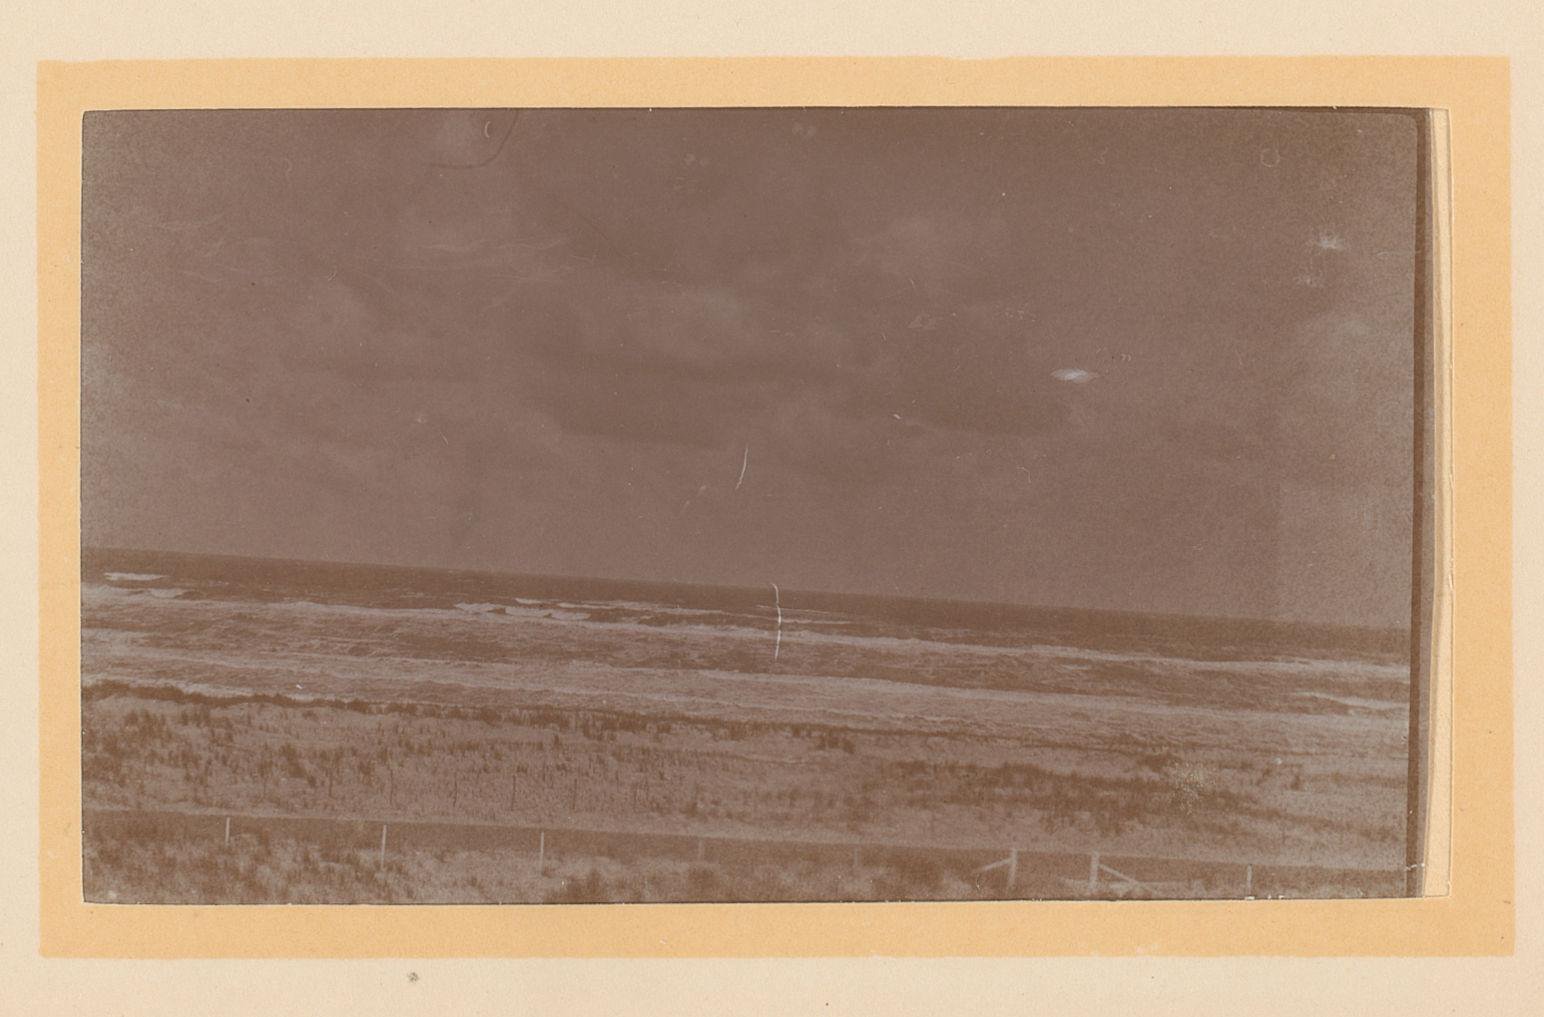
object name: photograph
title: Gezicht op het strand en de zee vanaf de duinen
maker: Anonymous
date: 1927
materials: paper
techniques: gelatin silver print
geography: netherlands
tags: dune coast, beach, netherlands